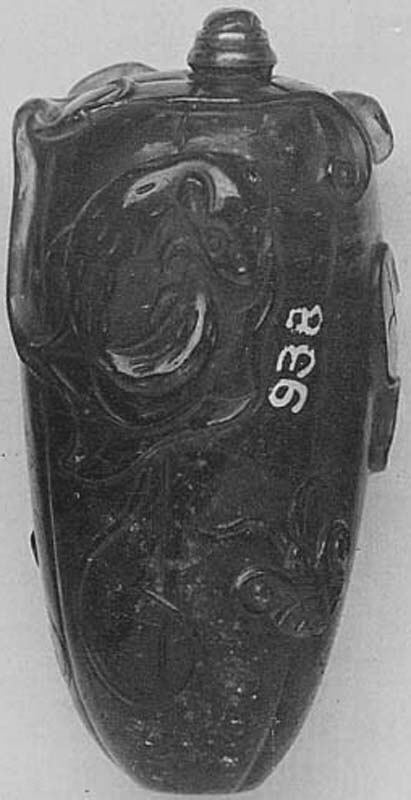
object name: snuff bottle with stopper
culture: chinese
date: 1701-1900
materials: quartz